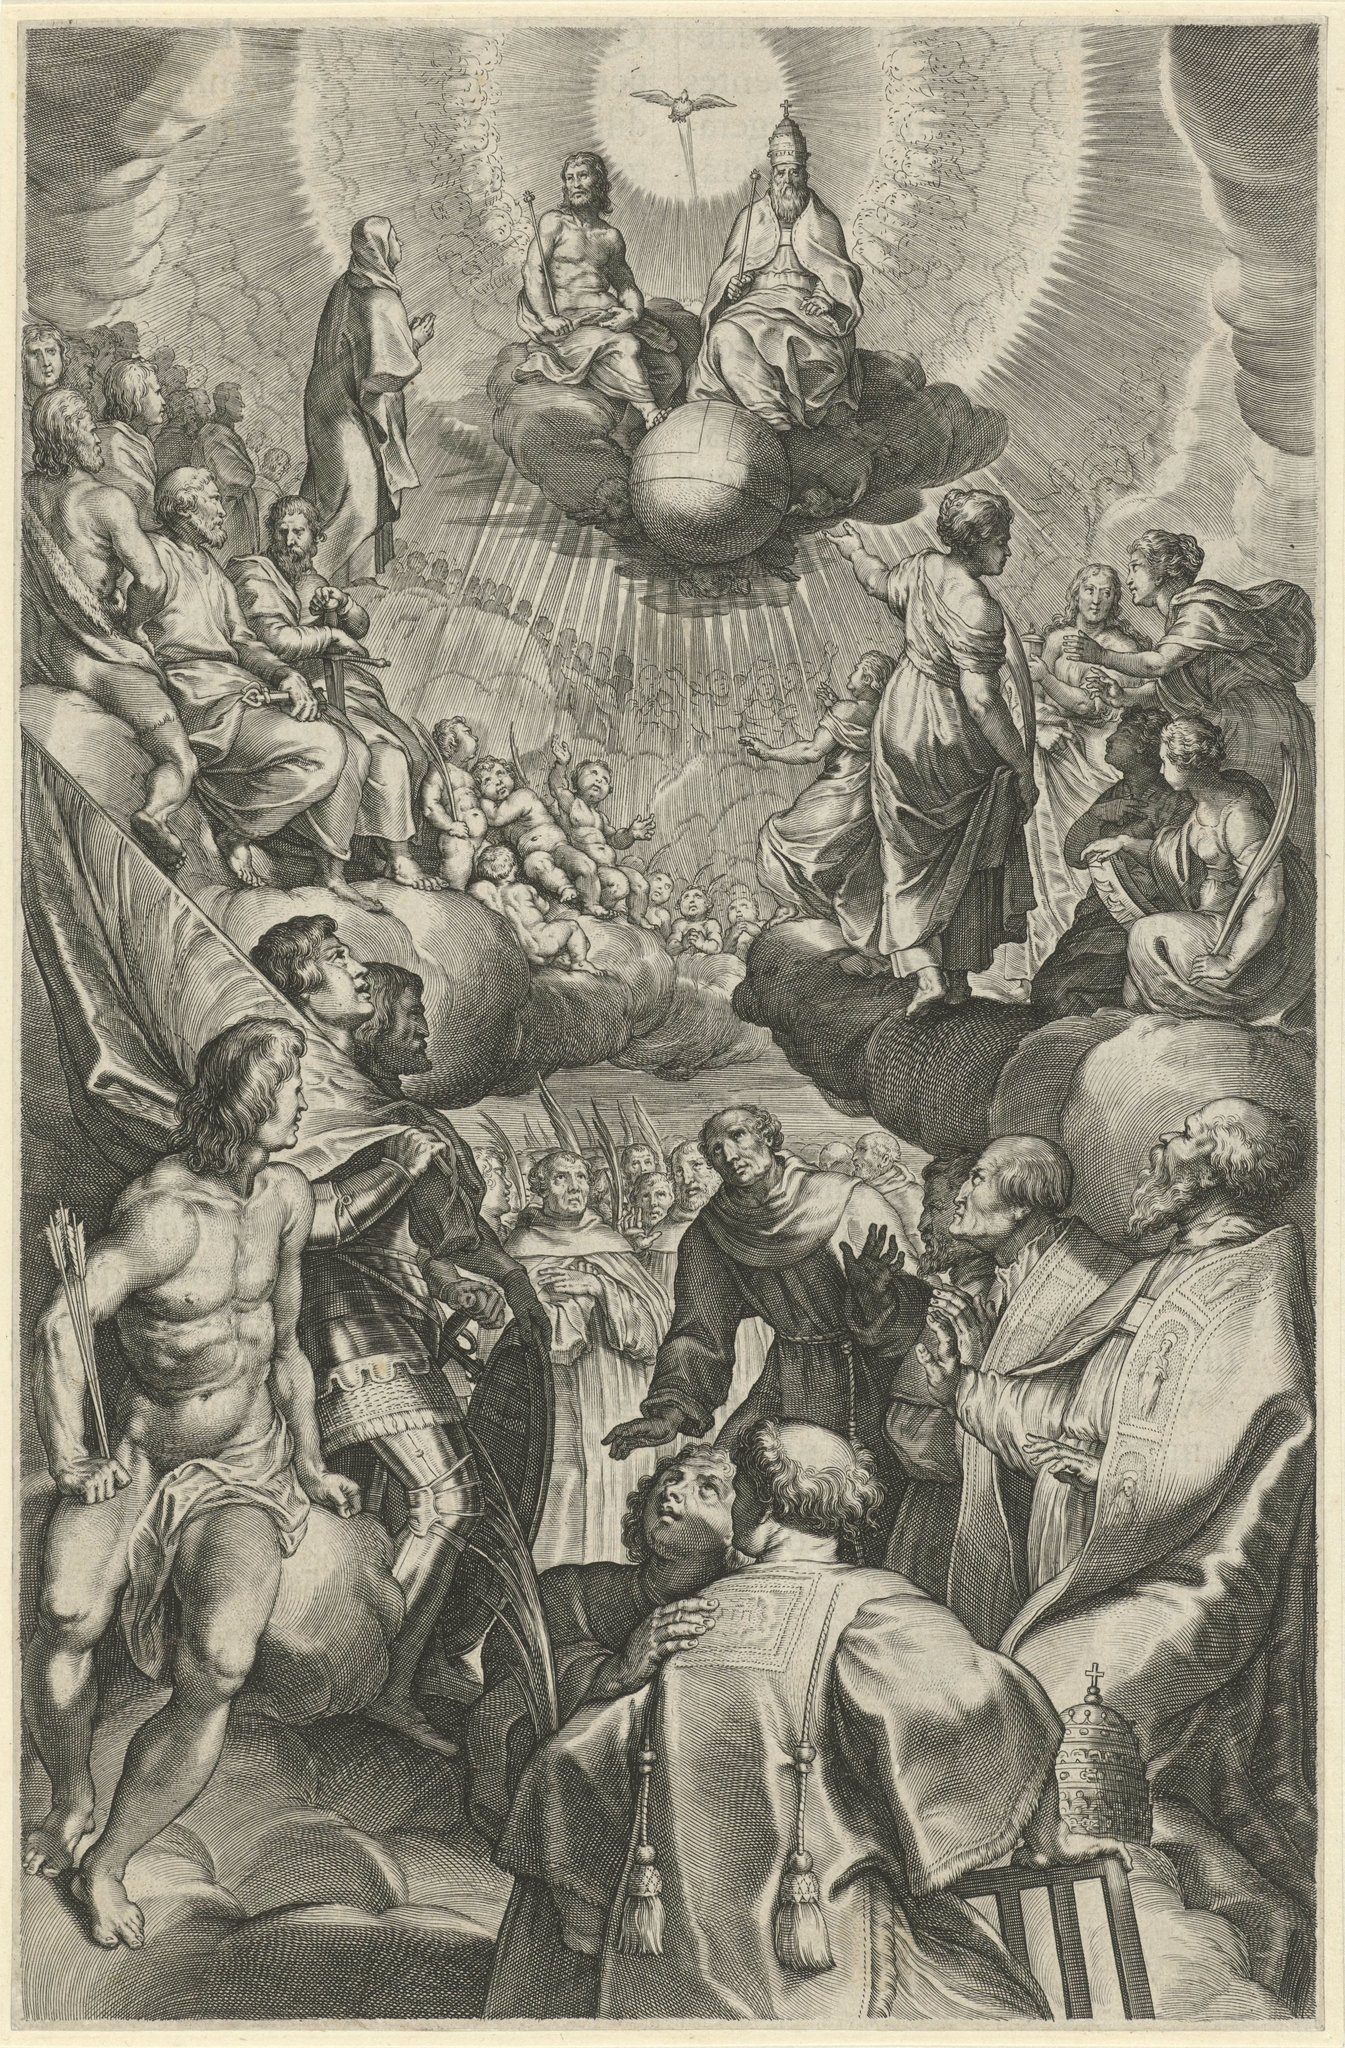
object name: print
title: Breviarium romanum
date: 1612-1616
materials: paper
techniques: engraving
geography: antwerp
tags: devotion: all saints picture, 'allerheiligenbild'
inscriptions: collector's mark: Lugt 240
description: Rondom de tronende Drieëenheid van Christus, God en de Heilige Geest zijn alle heiligen verzameld (o.a. de H. Sebastiaan, de H. Joris. de H. Catherina van Constantinopel, etc.). Maria staat naast de Drieëenheid. De prent heeft een Latijns onderschrift.